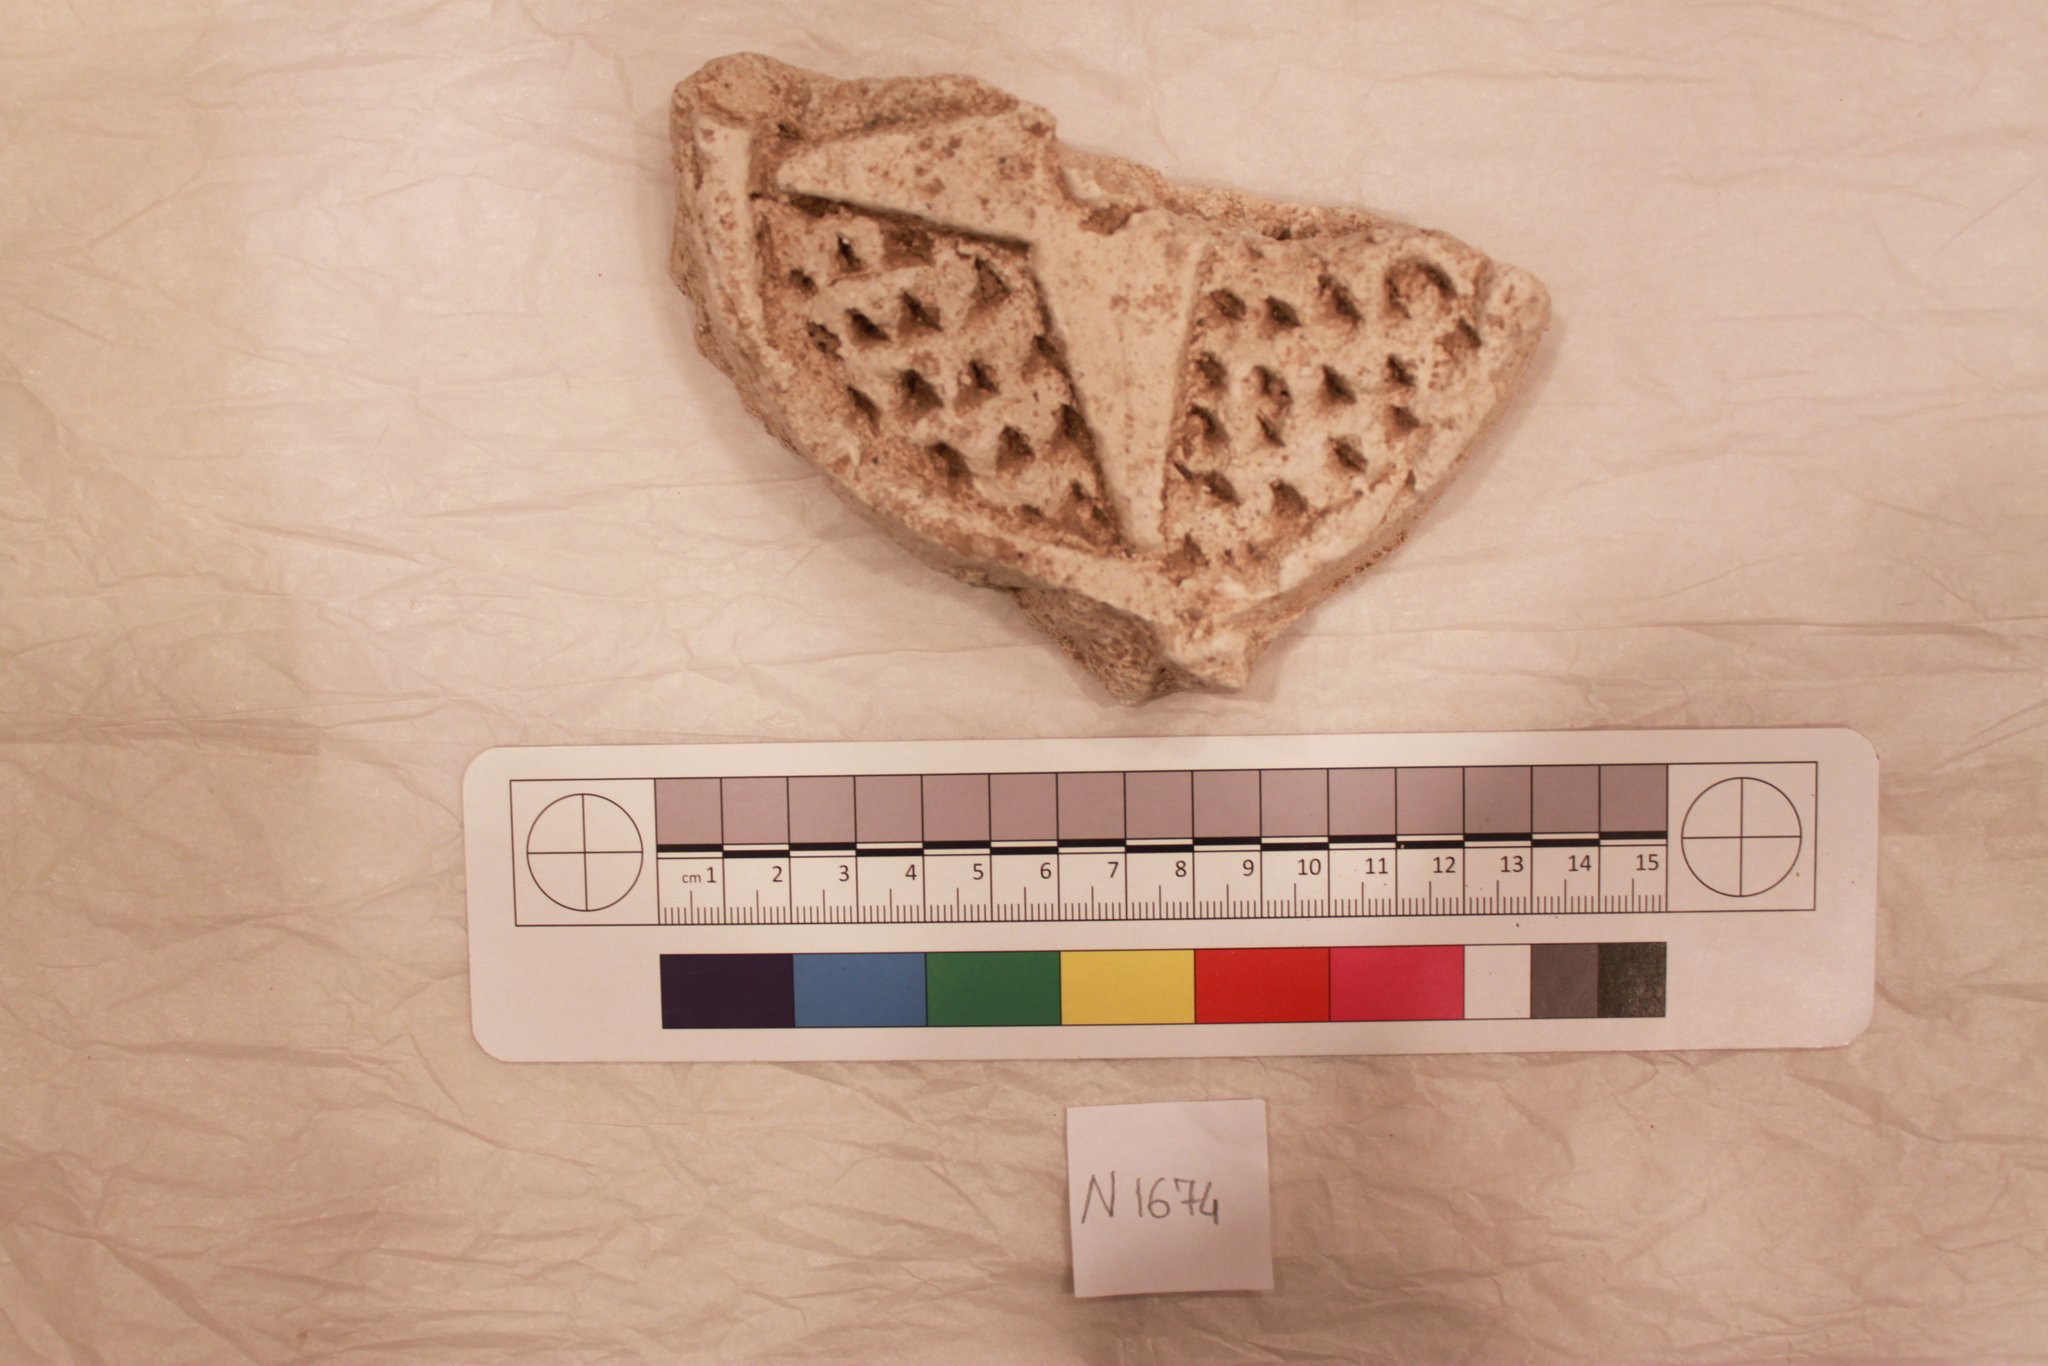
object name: fragment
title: Stucco Fragment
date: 701-1200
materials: plaster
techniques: carving, painting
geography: iran